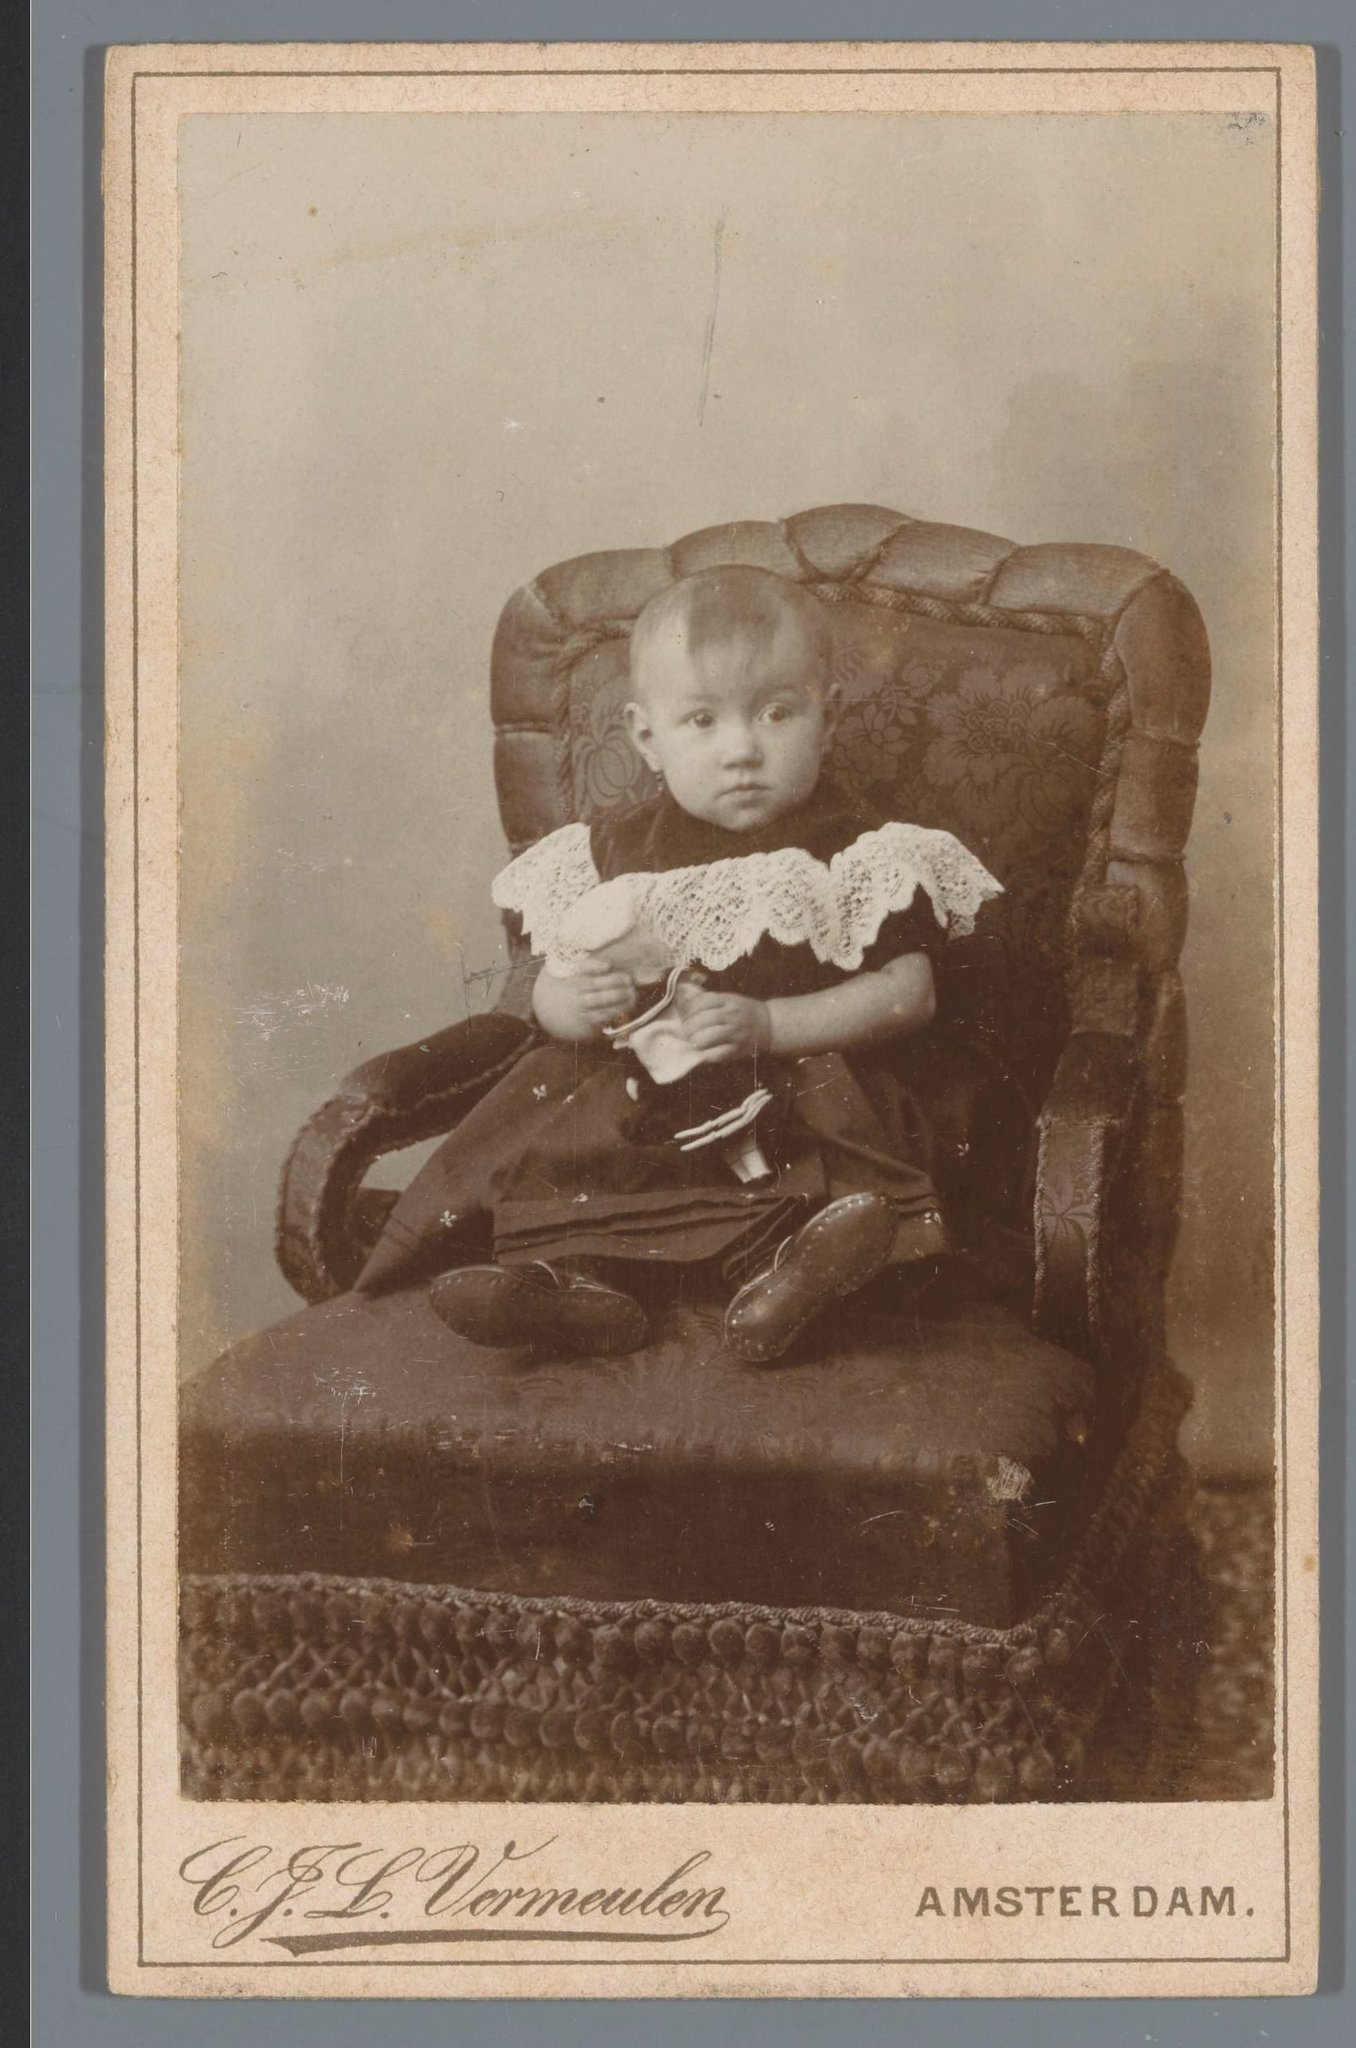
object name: photograph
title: Portret van een onbekend kind, zittend in een fauteuil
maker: cornelis johannes lodewicus vermeulen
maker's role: fotograaf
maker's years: 1861-1936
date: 1890-1915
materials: cardboard, photographic support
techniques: daylight paper print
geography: amsterdam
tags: historical persons, infant, baby, chair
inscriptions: inscription: ‘Photographische/ ATELIERS/ C. J. L. Vermeulen/ Heerenstraat 6,/ Heiligenweg/ hoek Singel/ AMSTERDAM,/ Specialiteit in vergrootingen.’